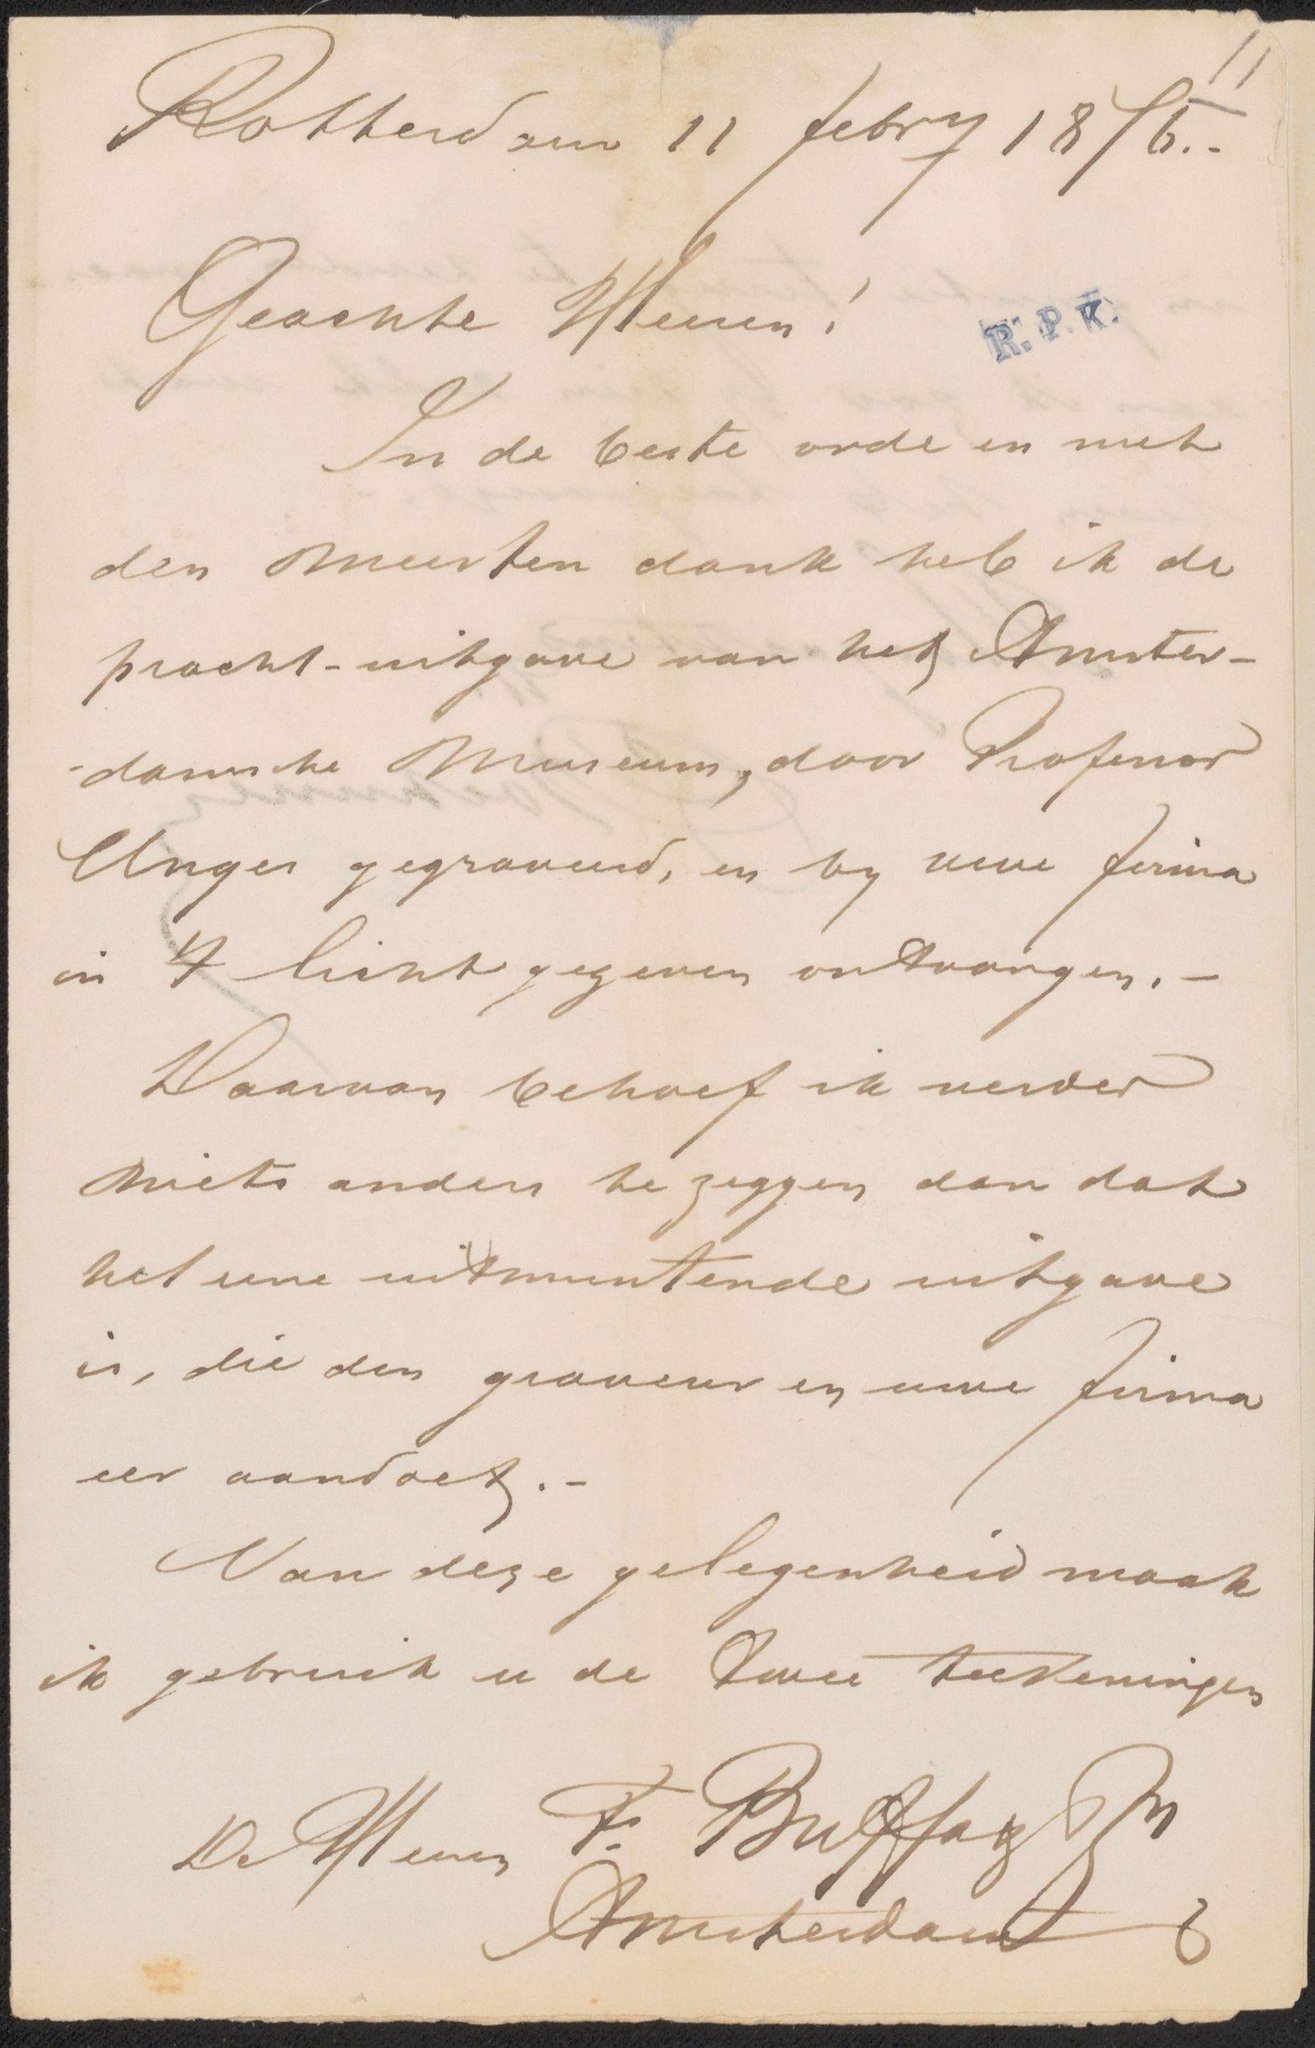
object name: letter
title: Brief aan Frans Buffa en Zonen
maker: charles rochussen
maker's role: draughtsman, painter, print maker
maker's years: 1814-1894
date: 1876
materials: ink, paper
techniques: pen, writing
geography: rotterdam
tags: publisher, william unger, rijksmuseum amsterdam, drawing, the graphic arts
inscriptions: collector's mark: Lugt 2233